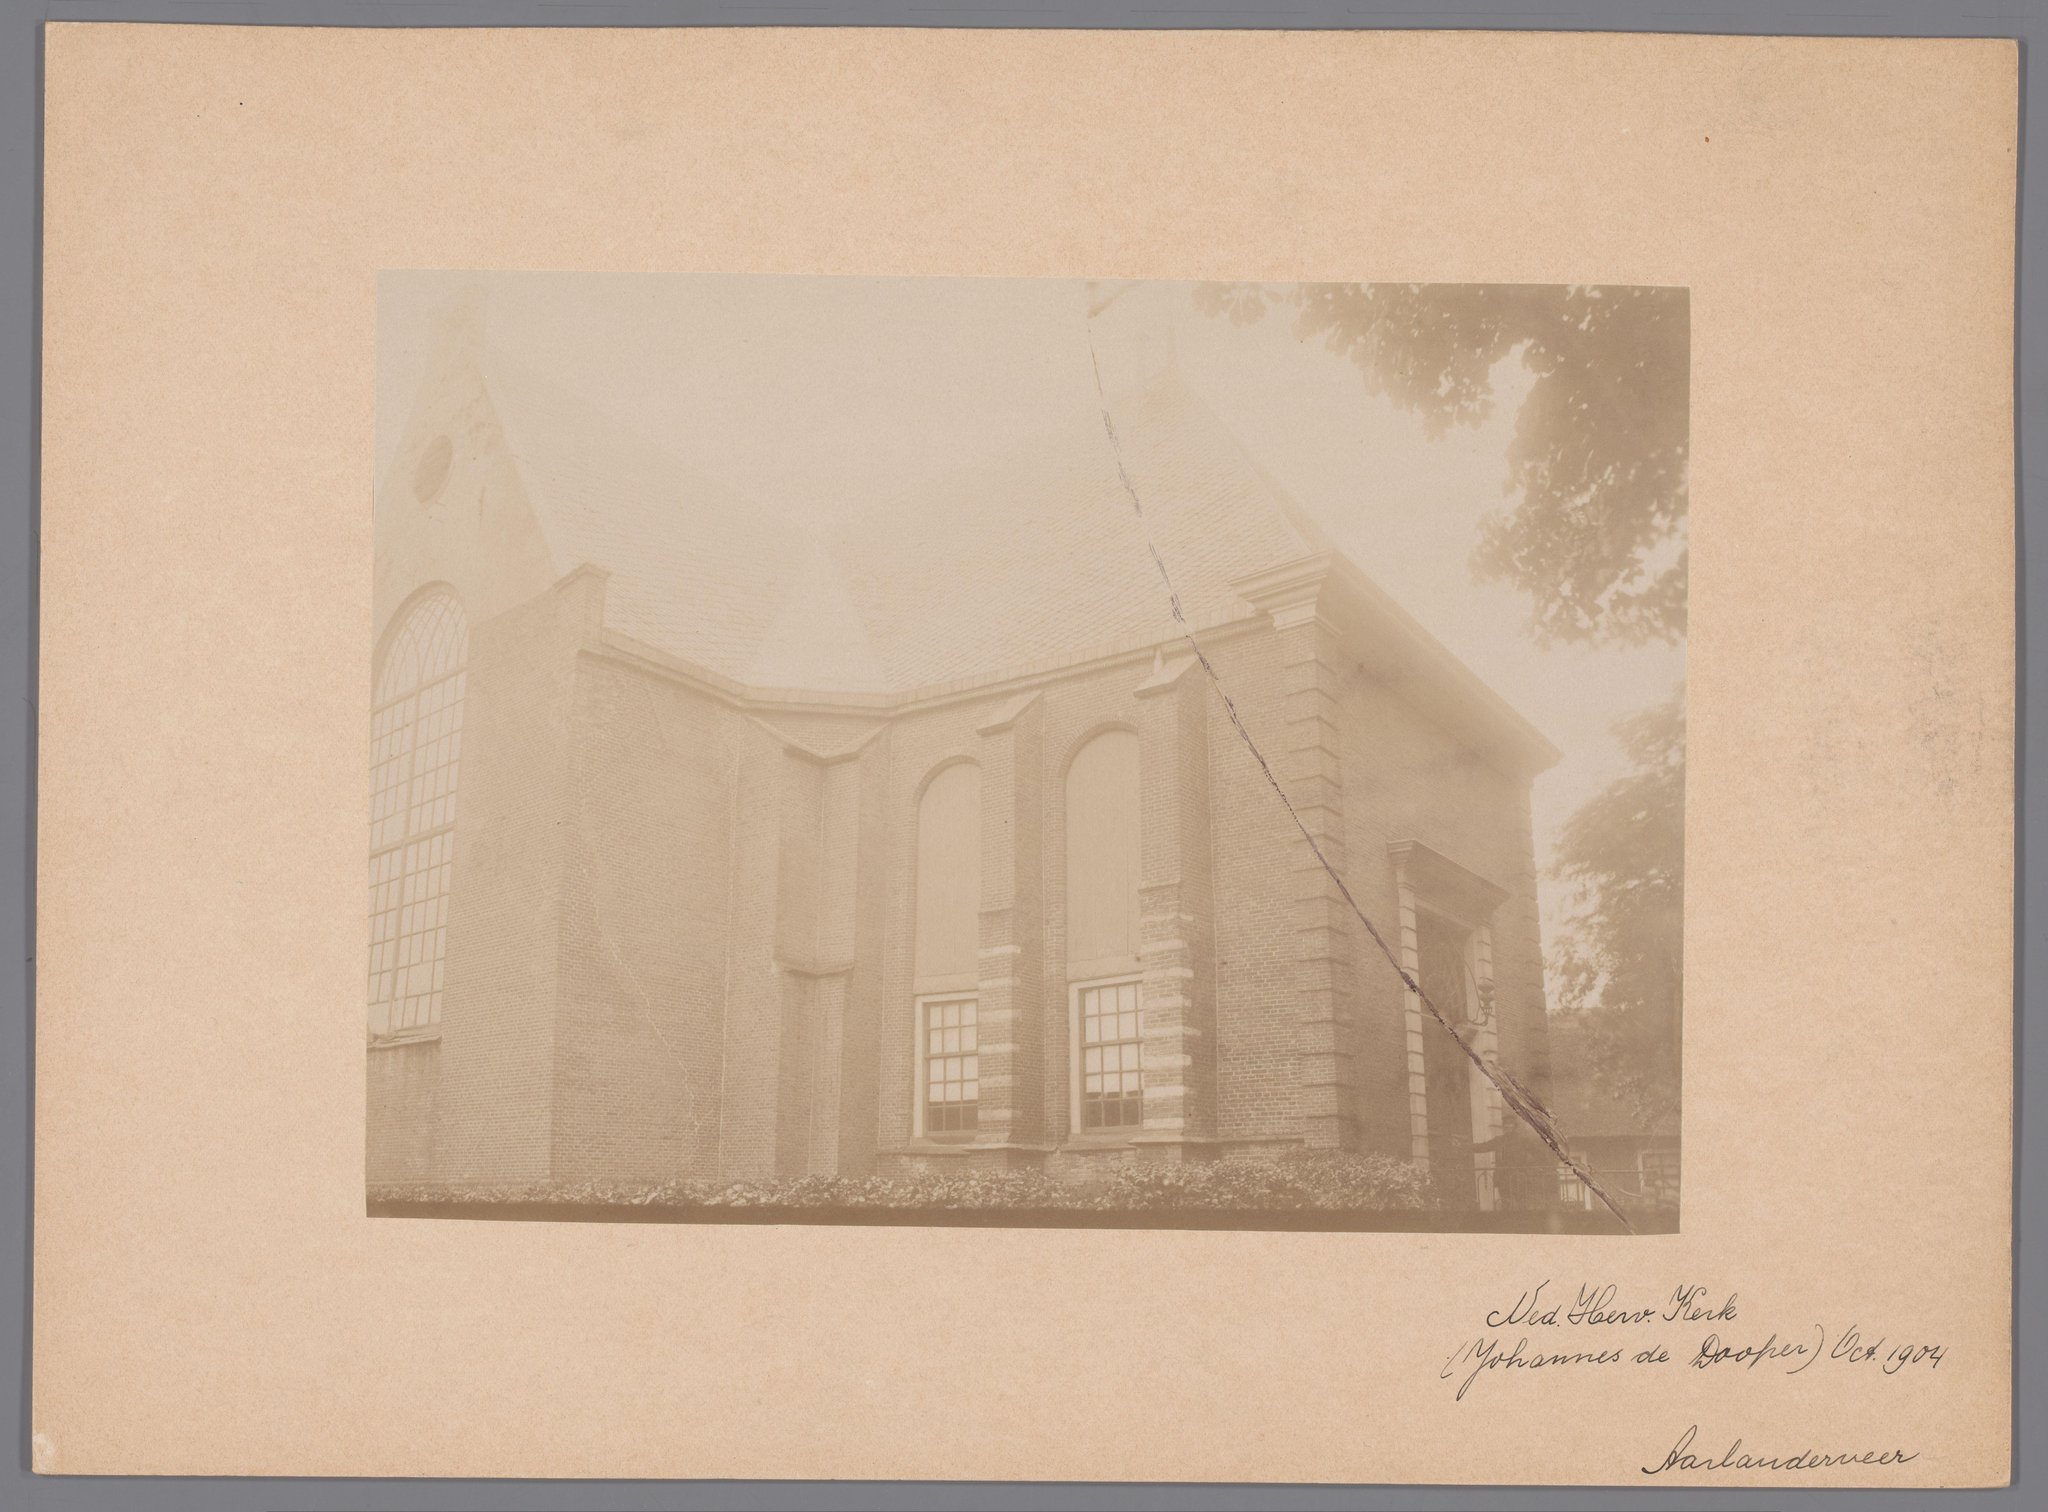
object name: photograph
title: Nederlands-hervormde kerk te Aarlanderveen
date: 1904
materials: cardboard, photographic support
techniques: albumen print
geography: aarlanderveen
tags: church (exterior)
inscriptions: annotation: ‘Ned. Herv. Kerk (Johannes de Dooper) Oct. 1904/ Aarlanderveen’, annotation: ‘Aarlanderveen (Z.H.)/ Oct. 1904’